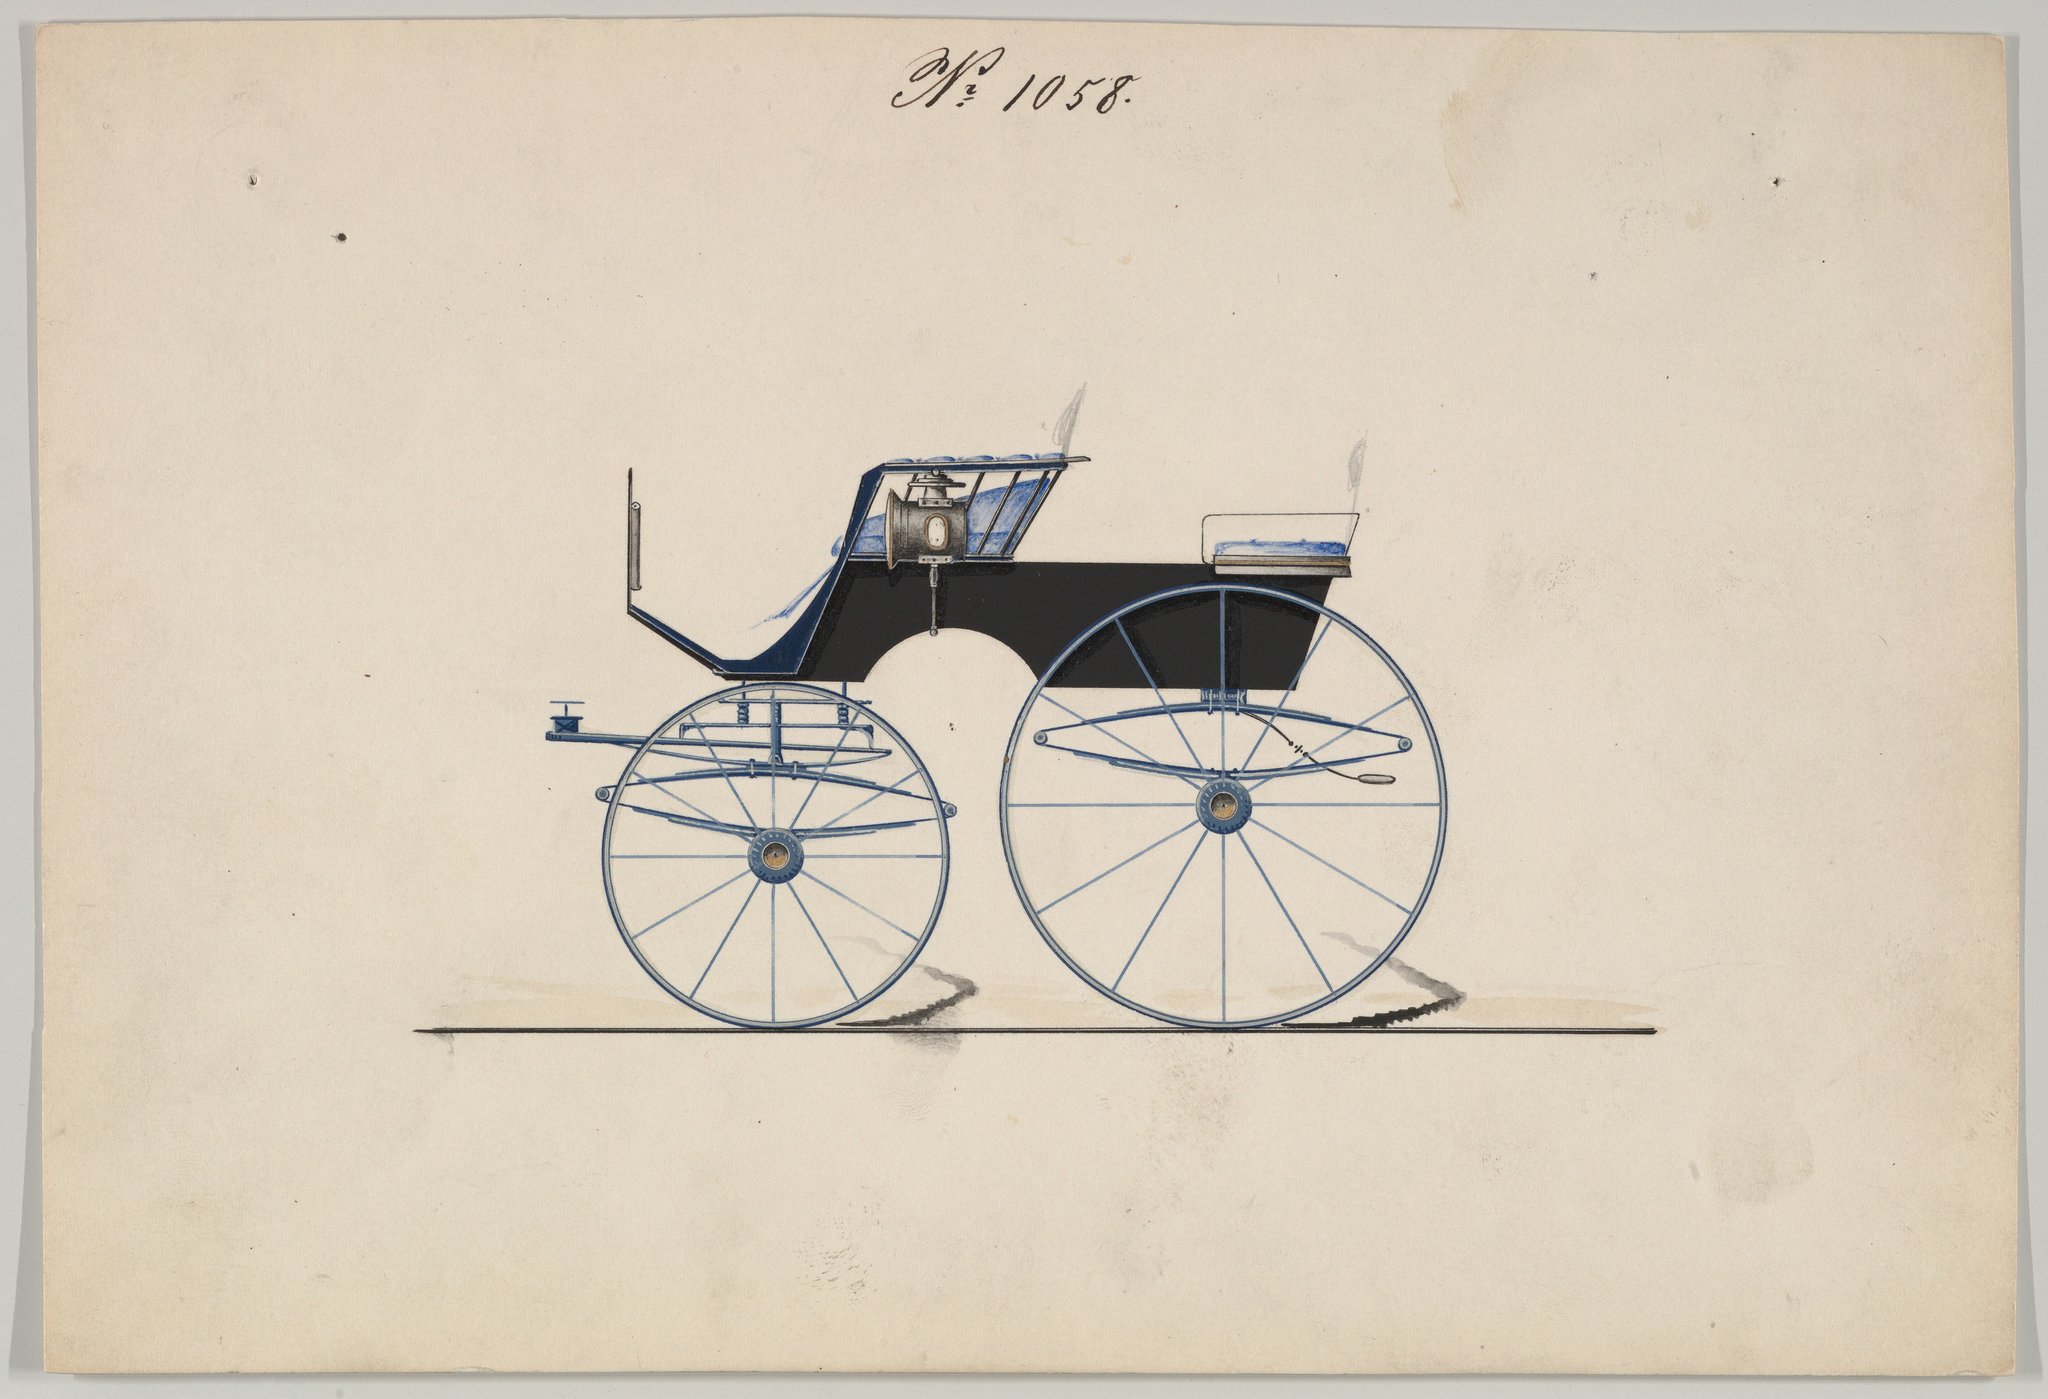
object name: drawing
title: T-Cart Phaeton #1058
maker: brewster & co.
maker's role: manufacturer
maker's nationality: american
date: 1850-1870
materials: gouache, gum arabic, ink, watercolor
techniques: pen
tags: carriages